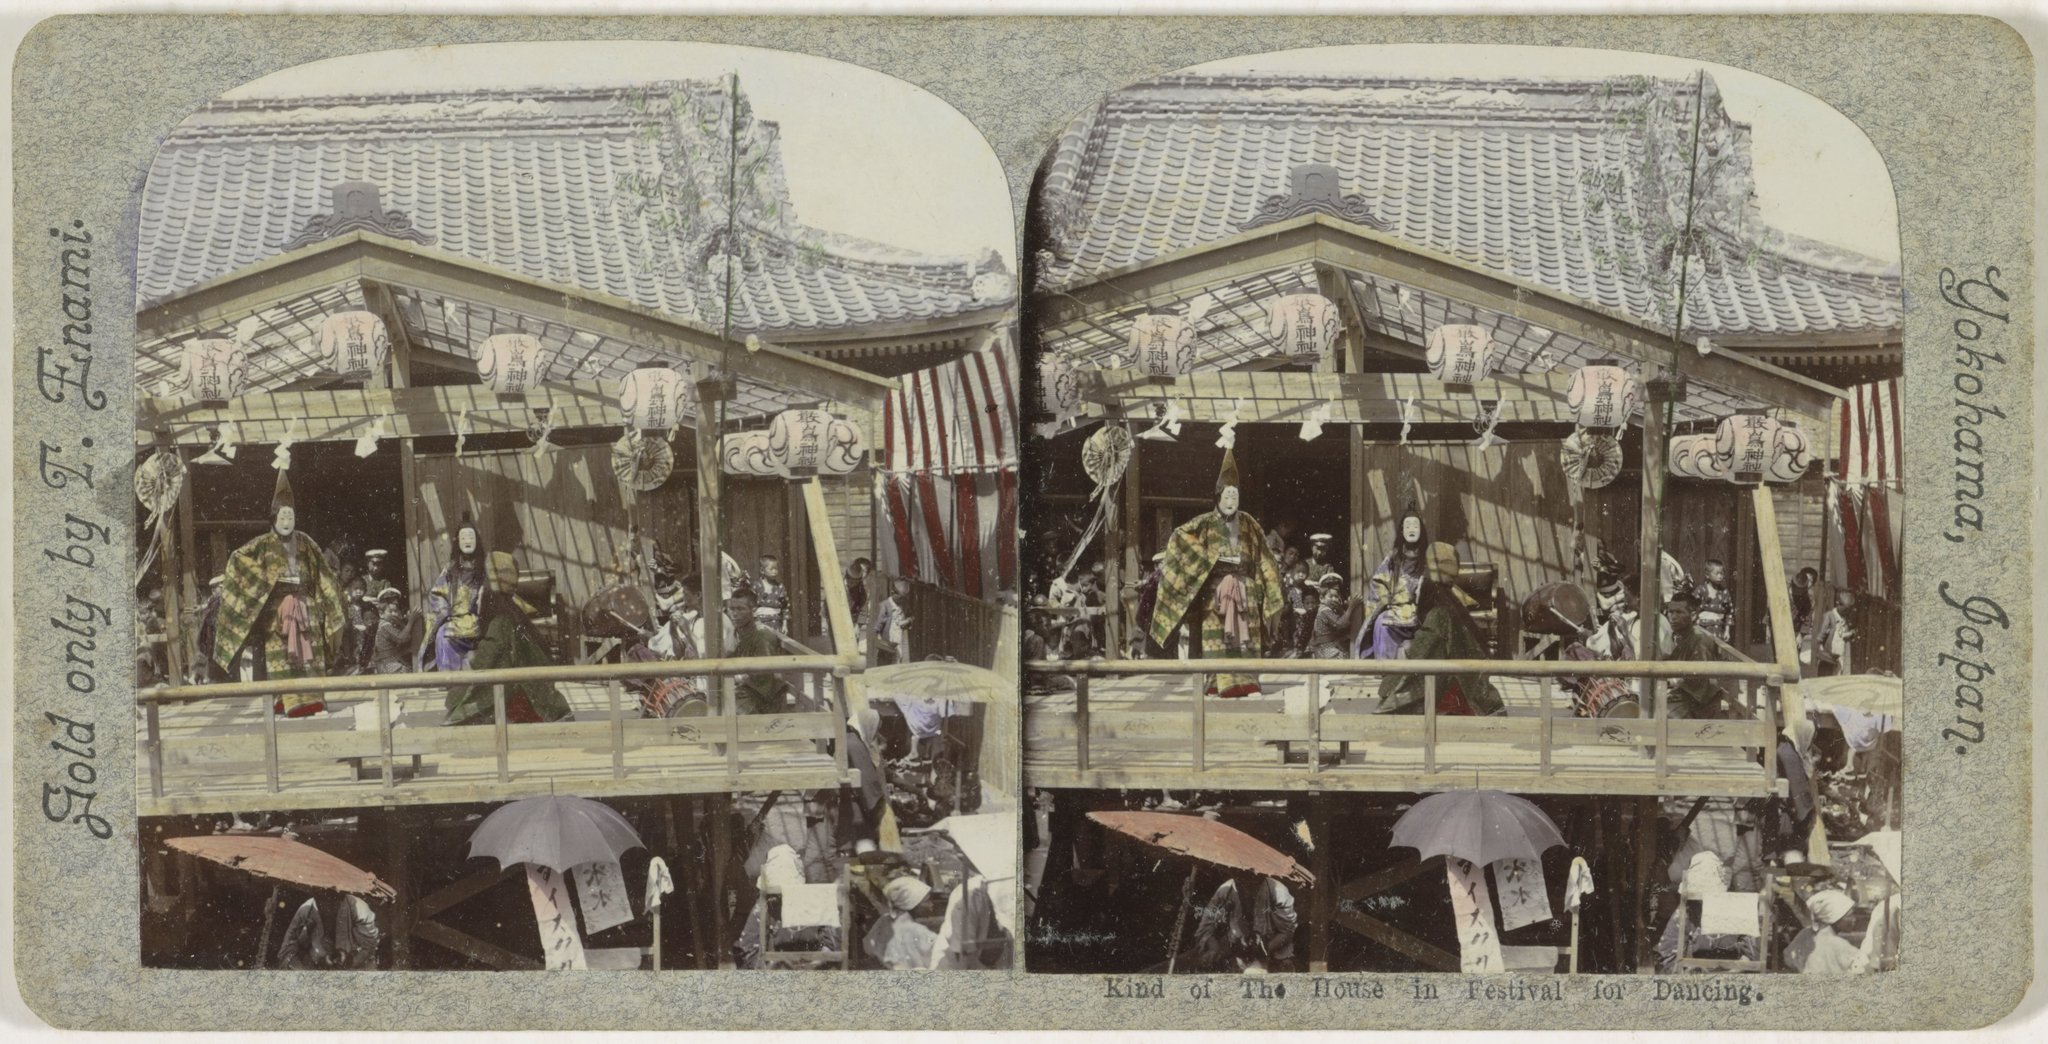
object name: stereograph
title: Dansoptreden in Japan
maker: t. enami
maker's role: publisher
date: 1900-1907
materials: paper, cardboard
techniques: hand coloring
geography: japan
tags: theatre, theatrical performance, japan